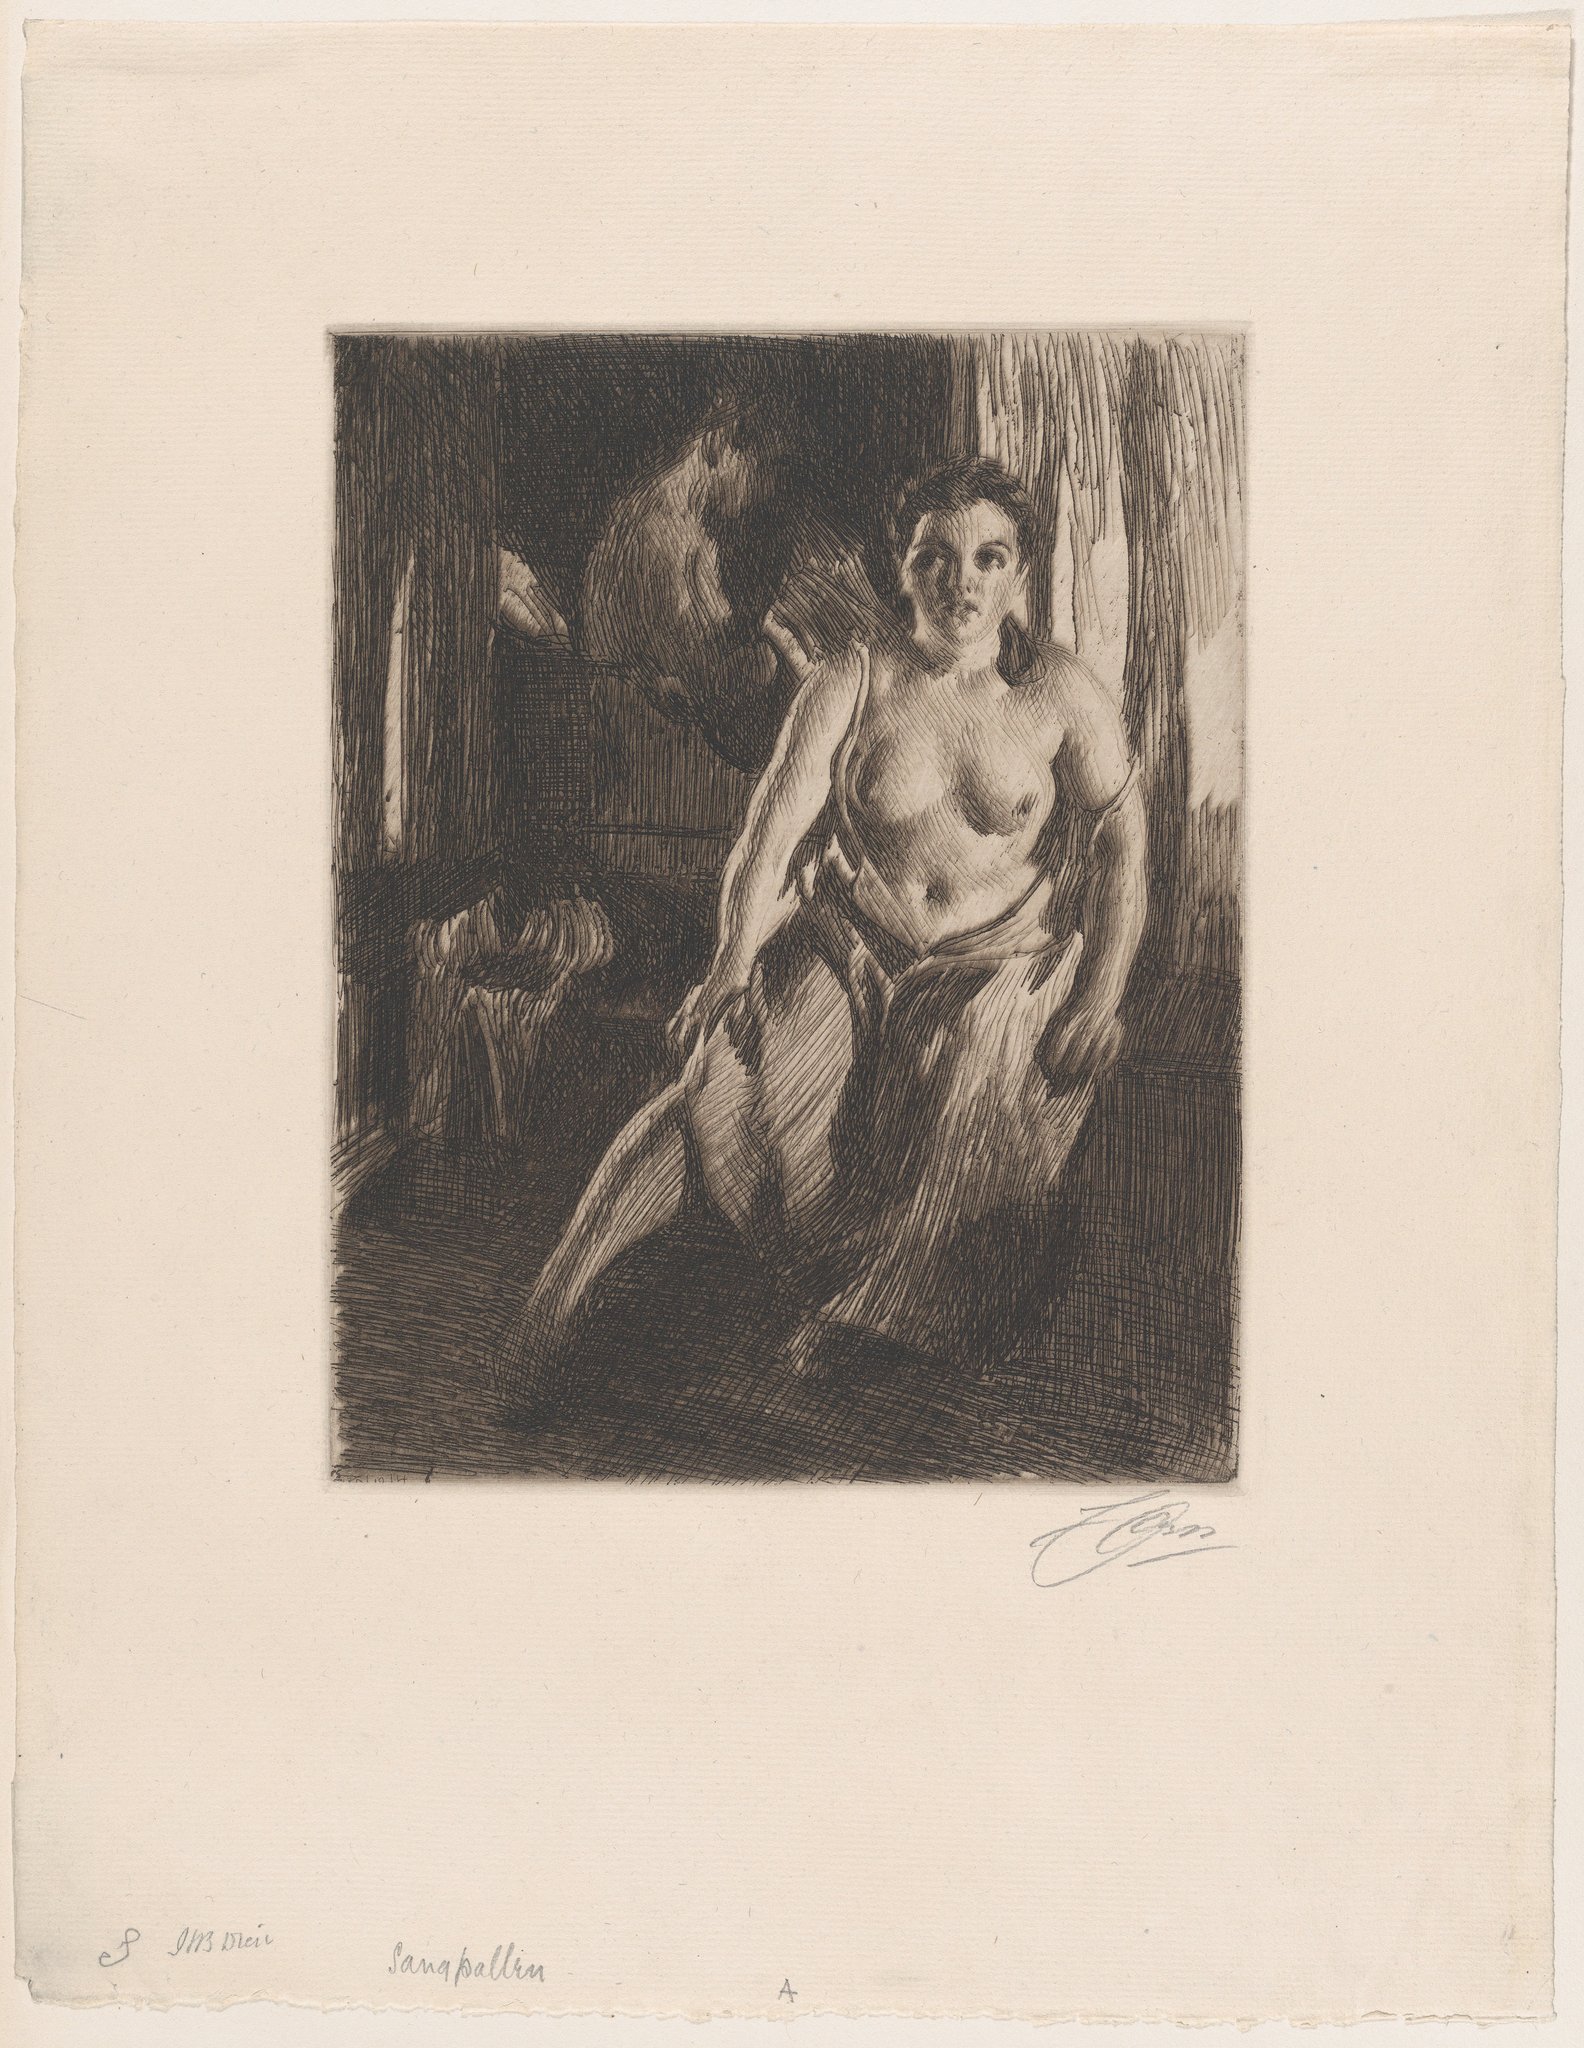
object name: print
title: The Bed-Stool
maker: anders zorn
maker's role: artist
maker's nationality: swedish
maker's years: 1860-1920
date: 1914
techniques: etching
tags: female nudes